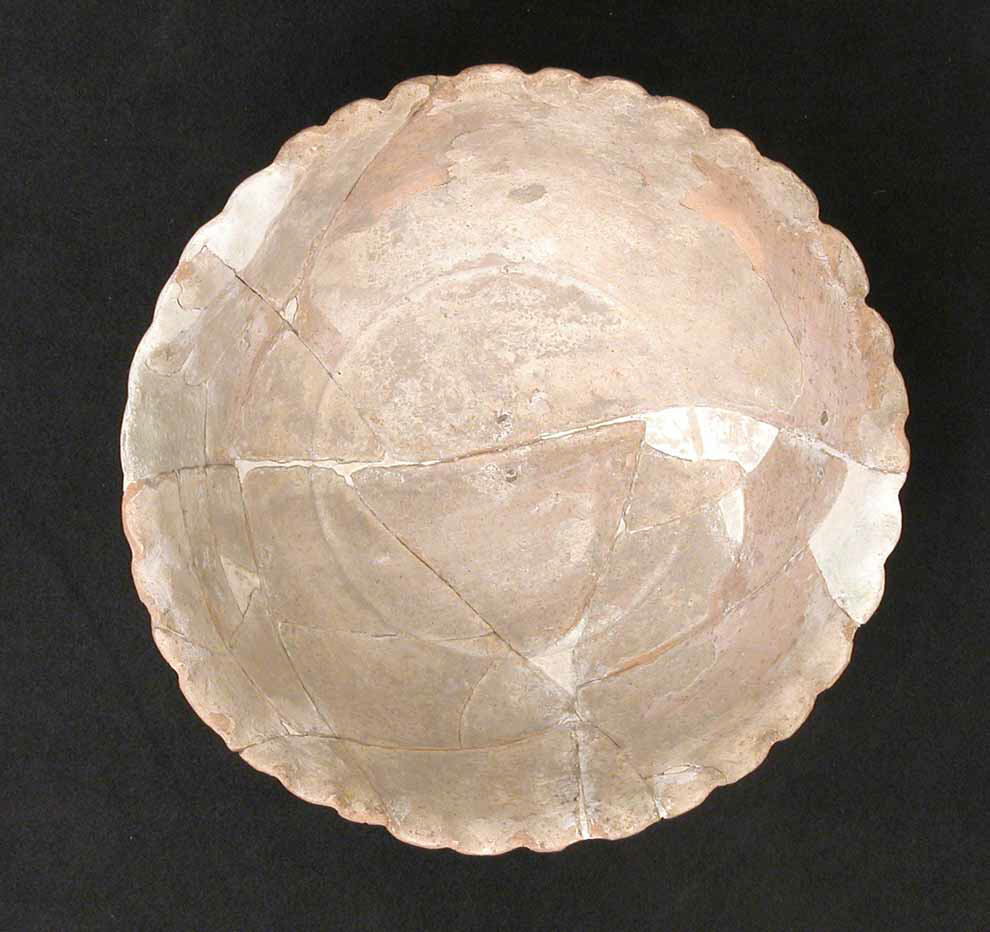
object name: bowl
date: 801-1000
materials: earthenware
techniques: glazing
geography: iran